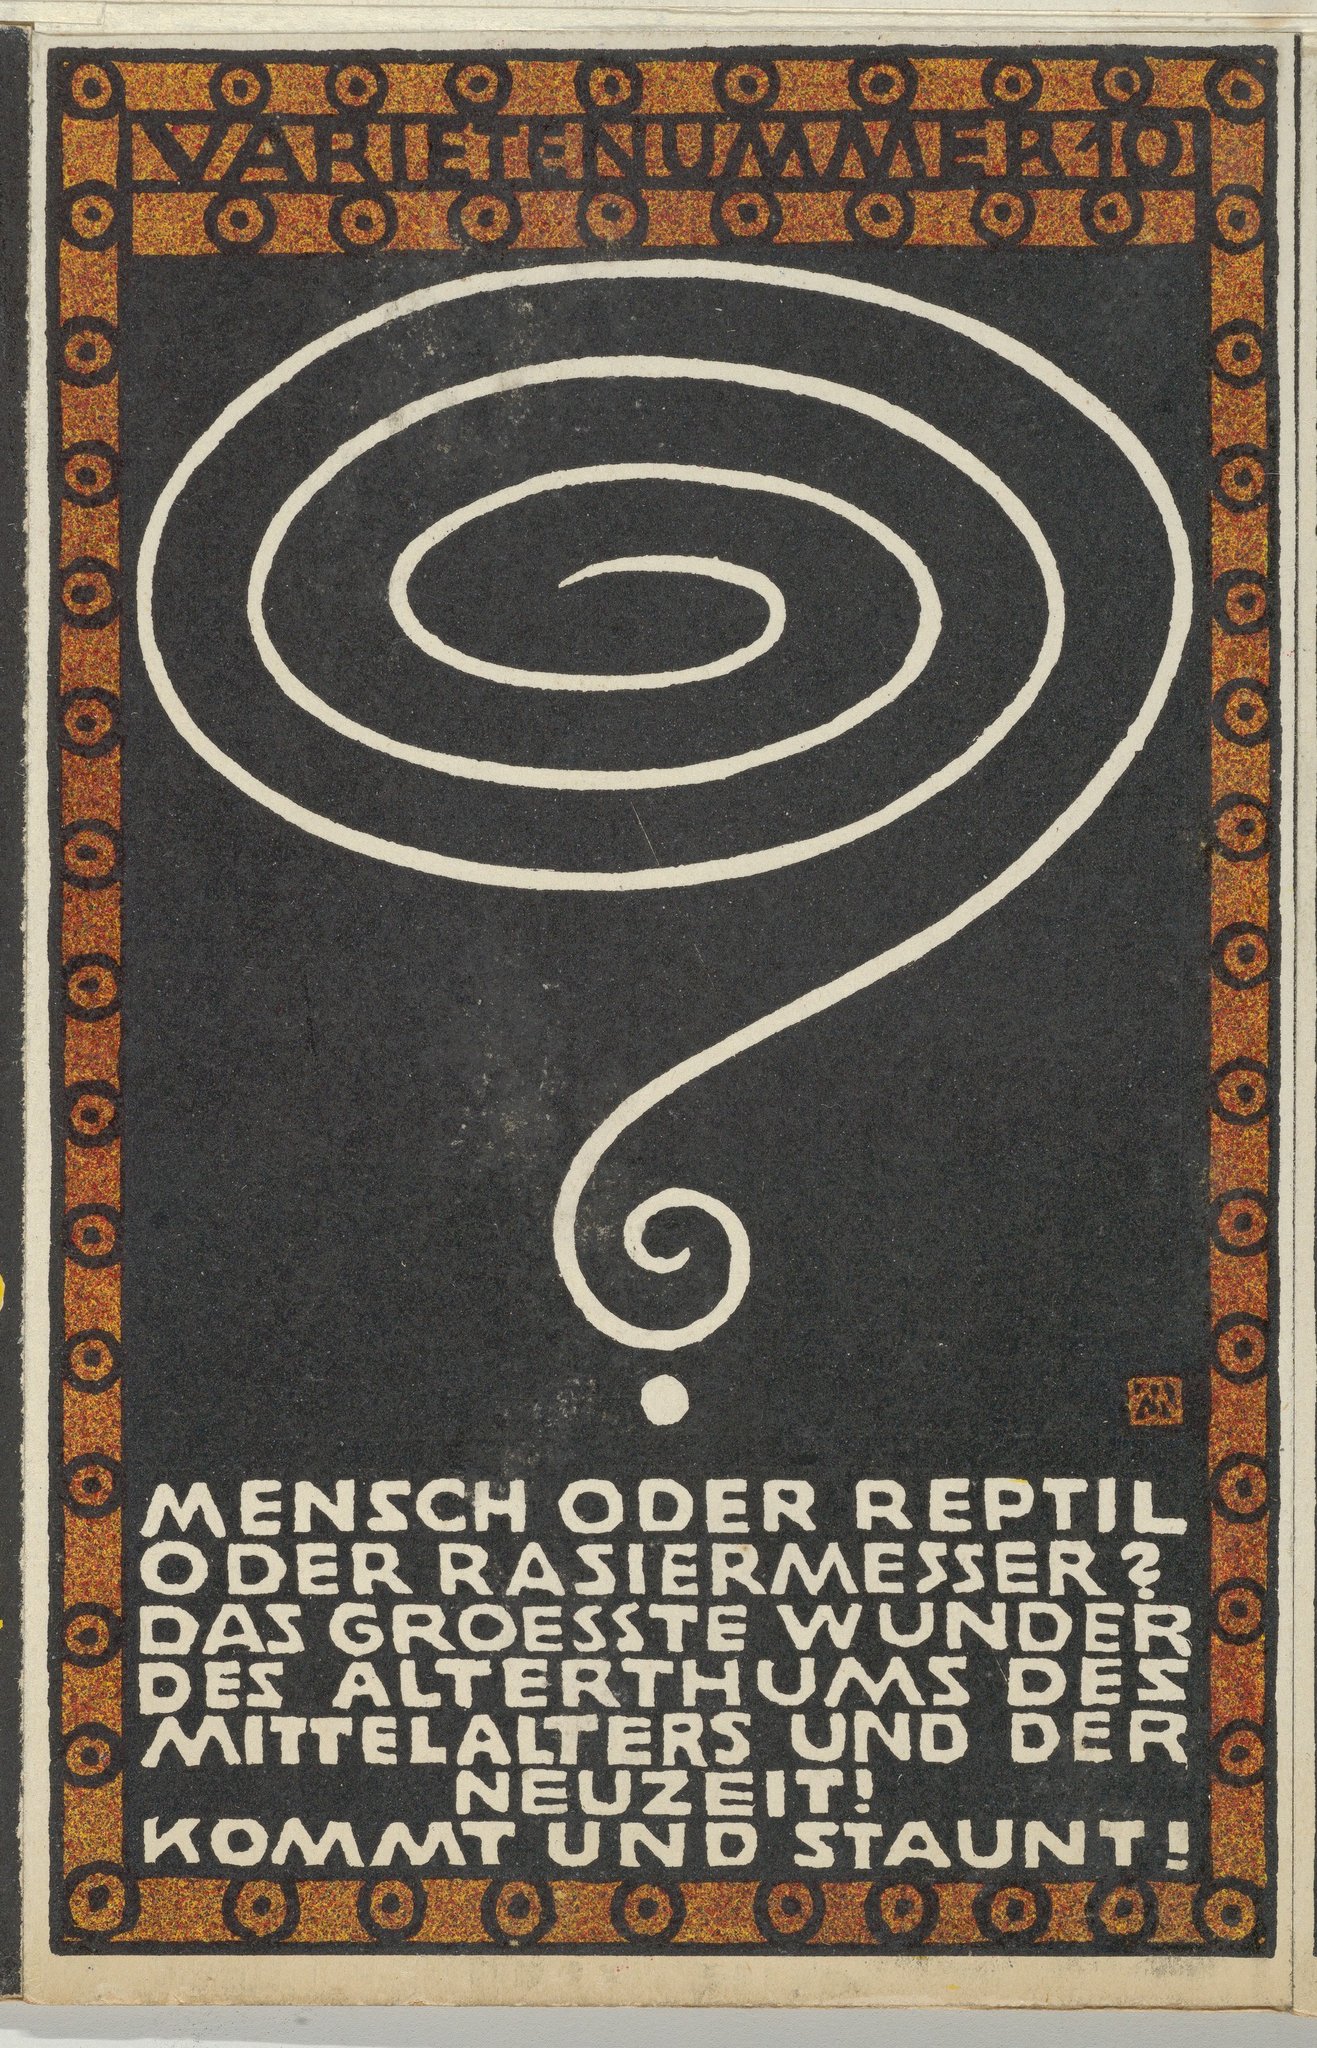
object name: print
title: Variety Act 10: Man or Reptile or Razor? (Varietenummer 10: Mensch oder Reptil oder Rasiermesser?)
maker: moriz jung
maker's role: artist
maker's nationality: austrian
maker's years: 1885-1915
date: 1907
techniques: lithograph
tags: abstraction